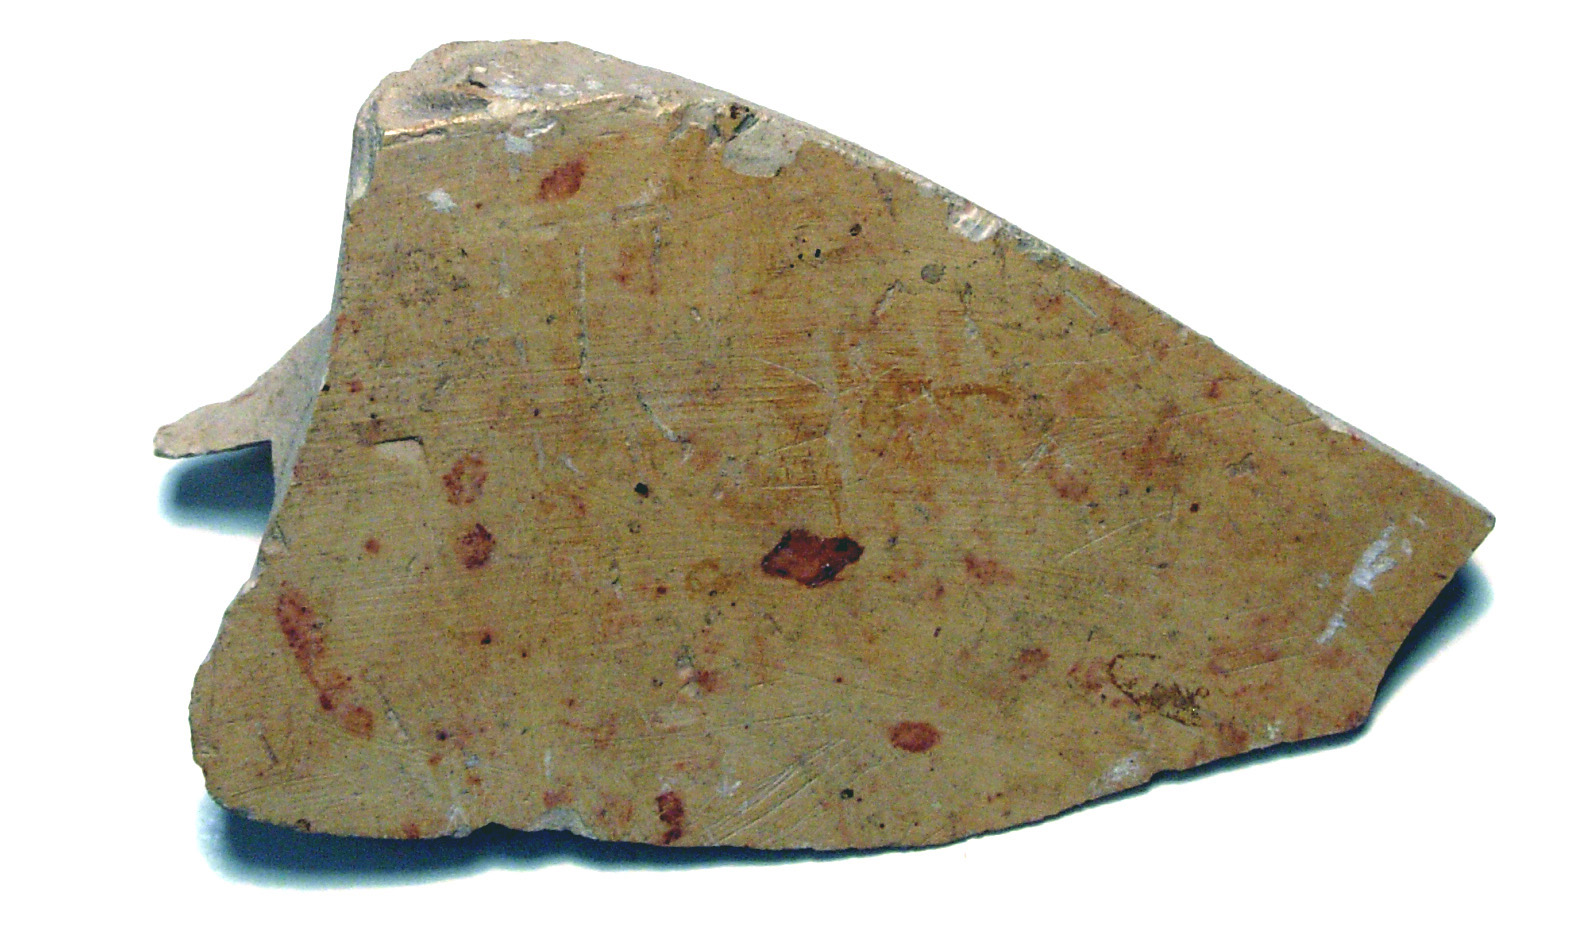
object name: relief, tomb of nespekashuty, wall casing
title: Wall casing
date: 664-610 BCE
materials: limestone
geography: egypt